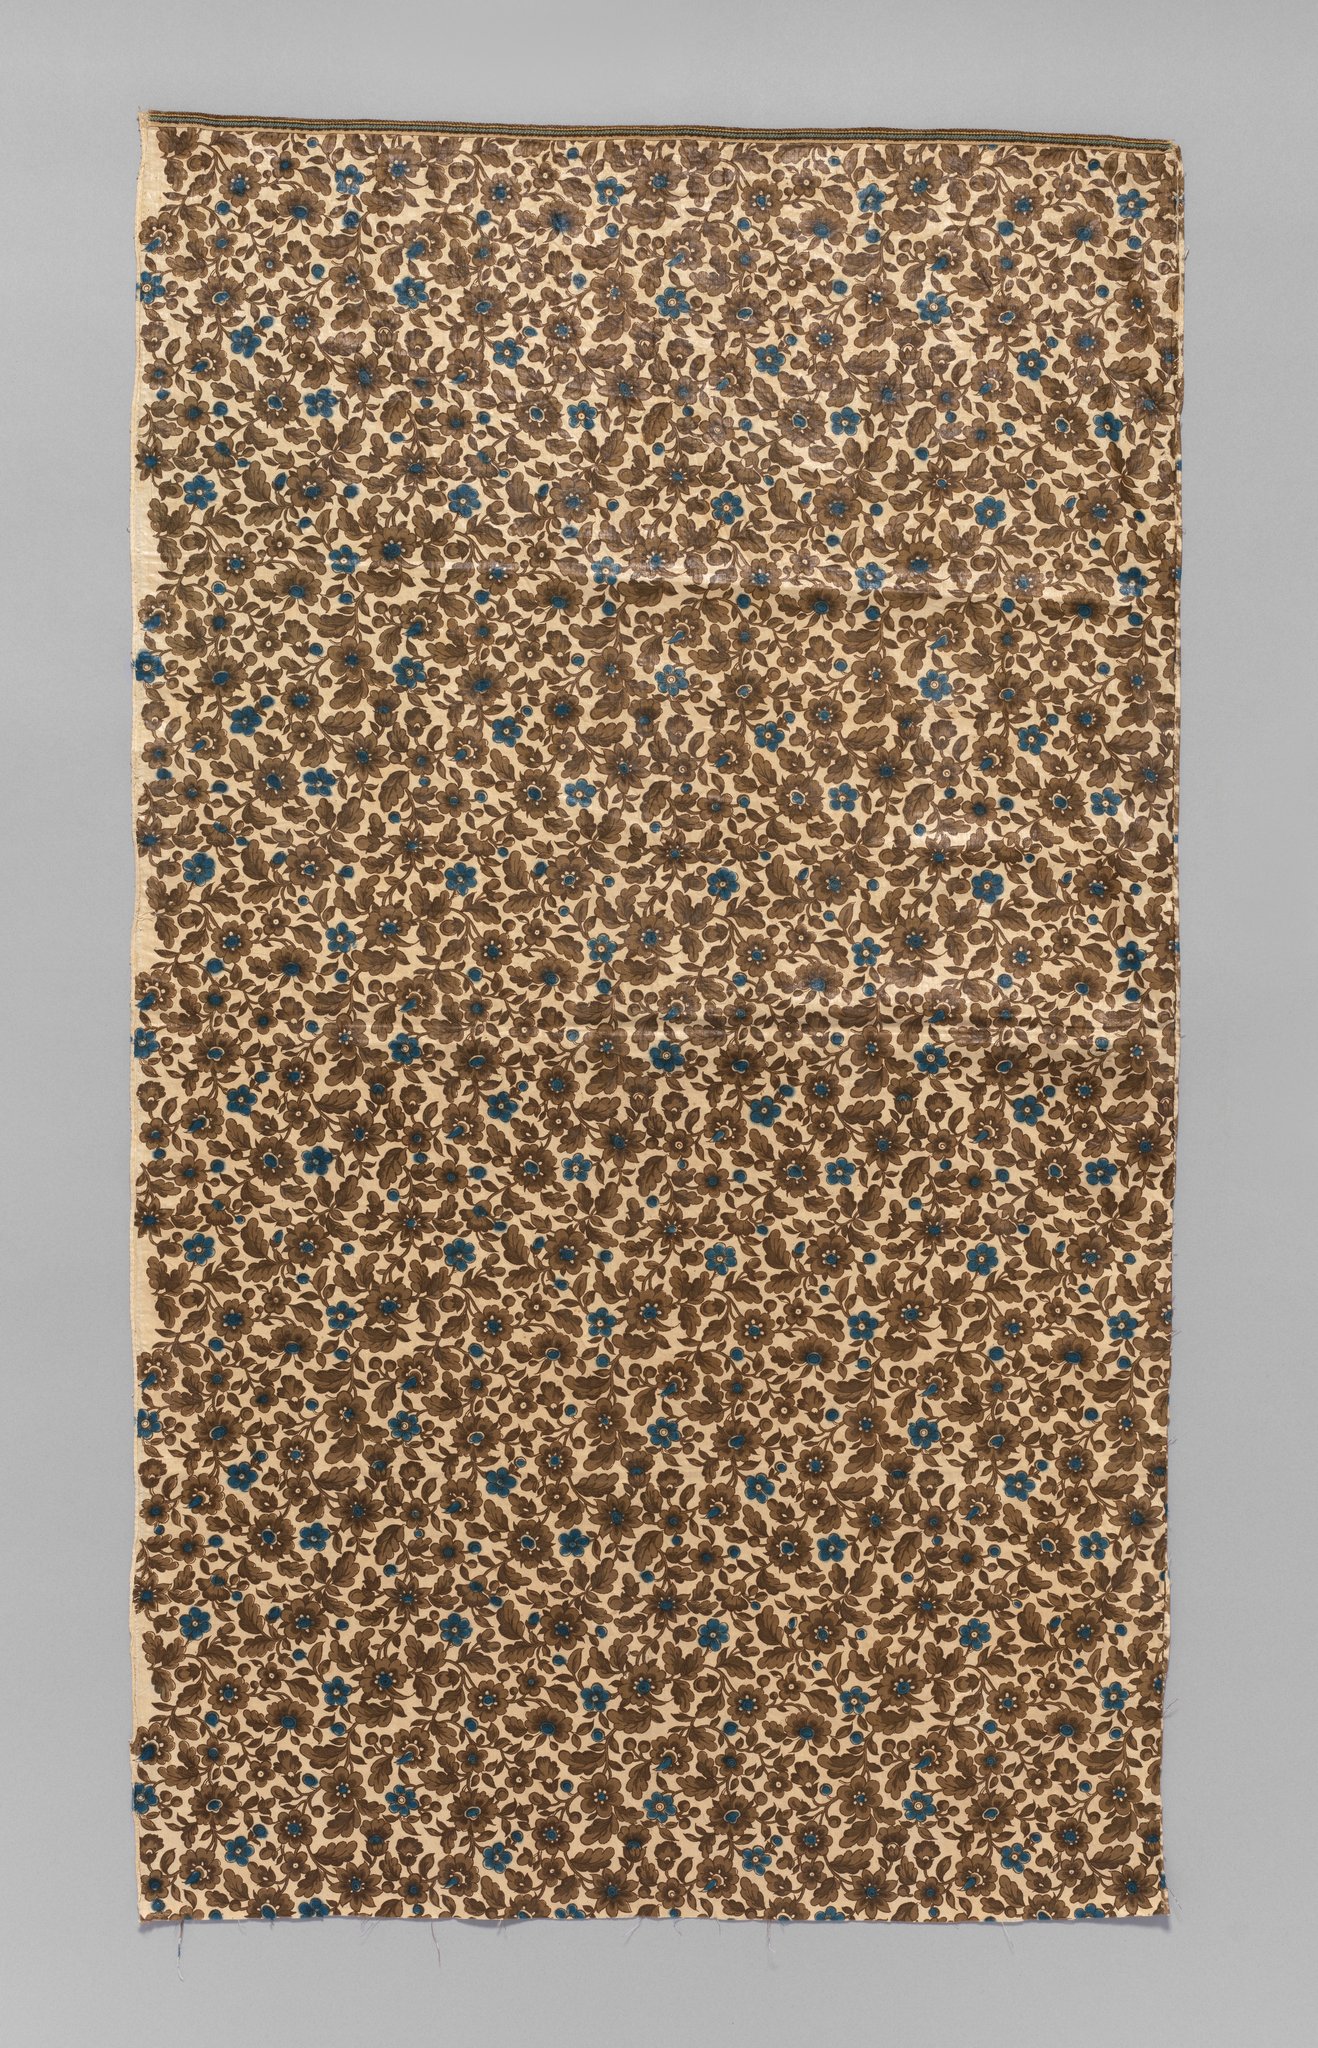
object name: piece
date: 1810-1815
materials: cotton